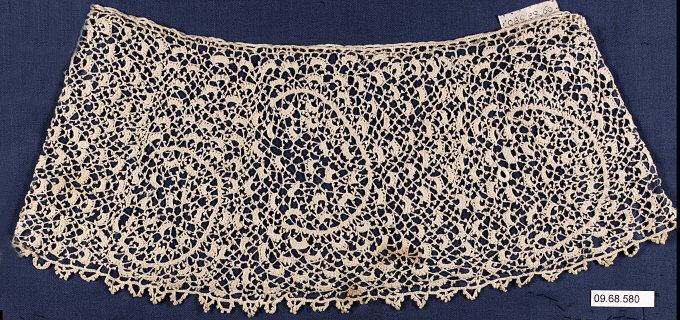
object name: cuff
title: Cuff (one of a pair)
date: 1801-1900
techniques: crochet